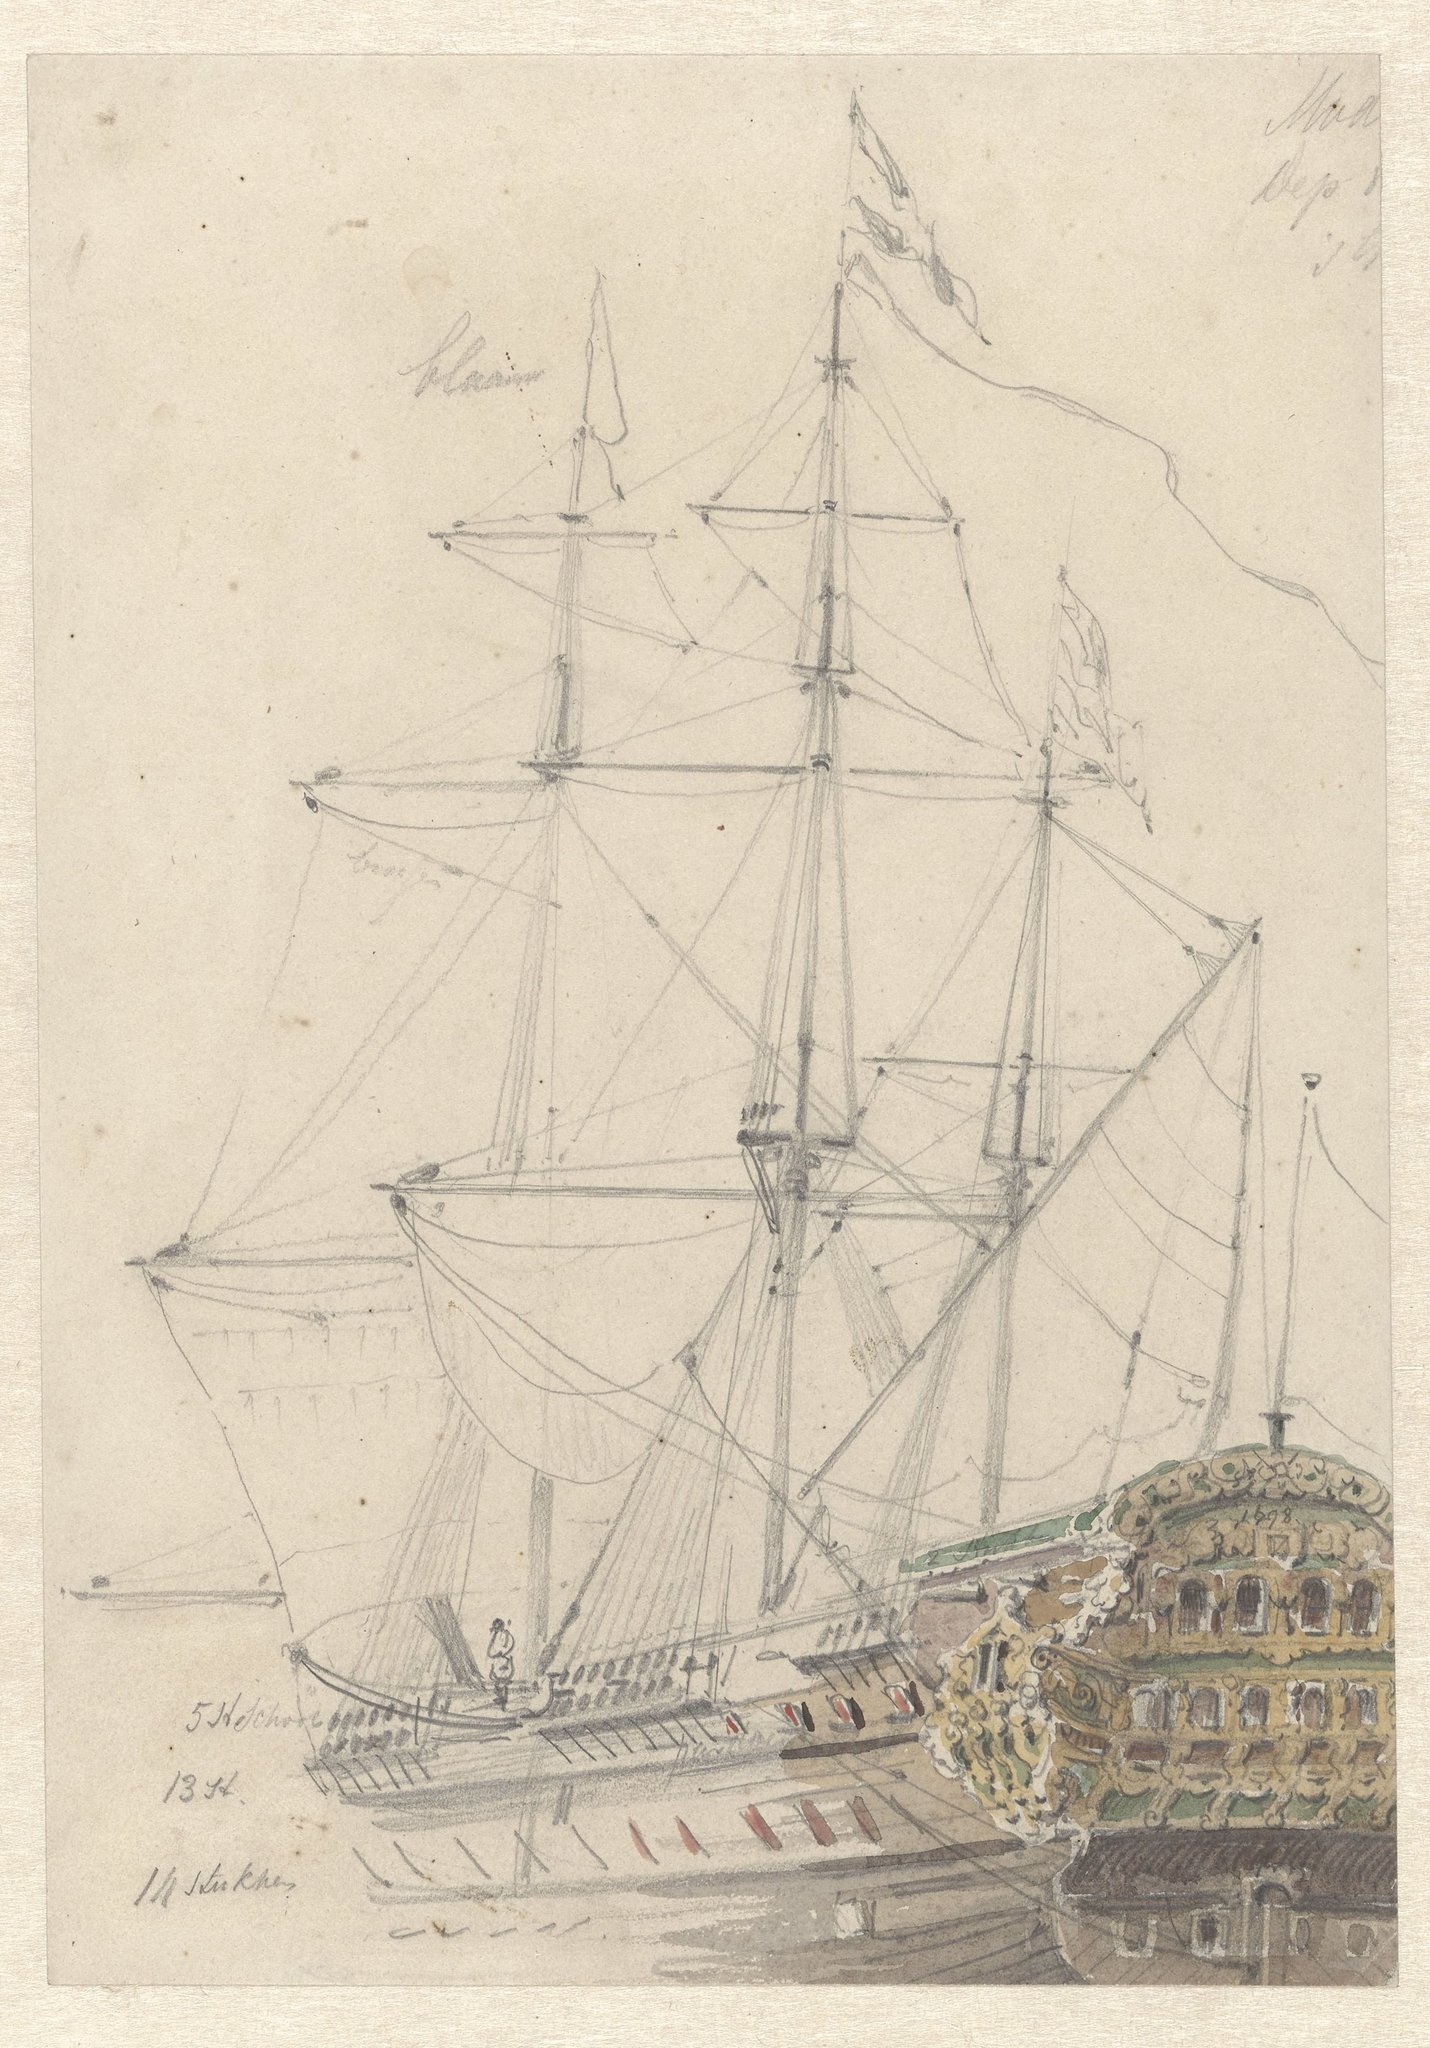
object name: drawing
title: Schets naar een model van een zeventiende eeuws Hollands fregat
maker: willem gruyter jr.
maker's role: draughtsman, print maker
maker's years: 1817-1880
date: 1827-1880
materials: chalk, paper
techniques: brush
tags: navy (+ sailing-ships), ship-model